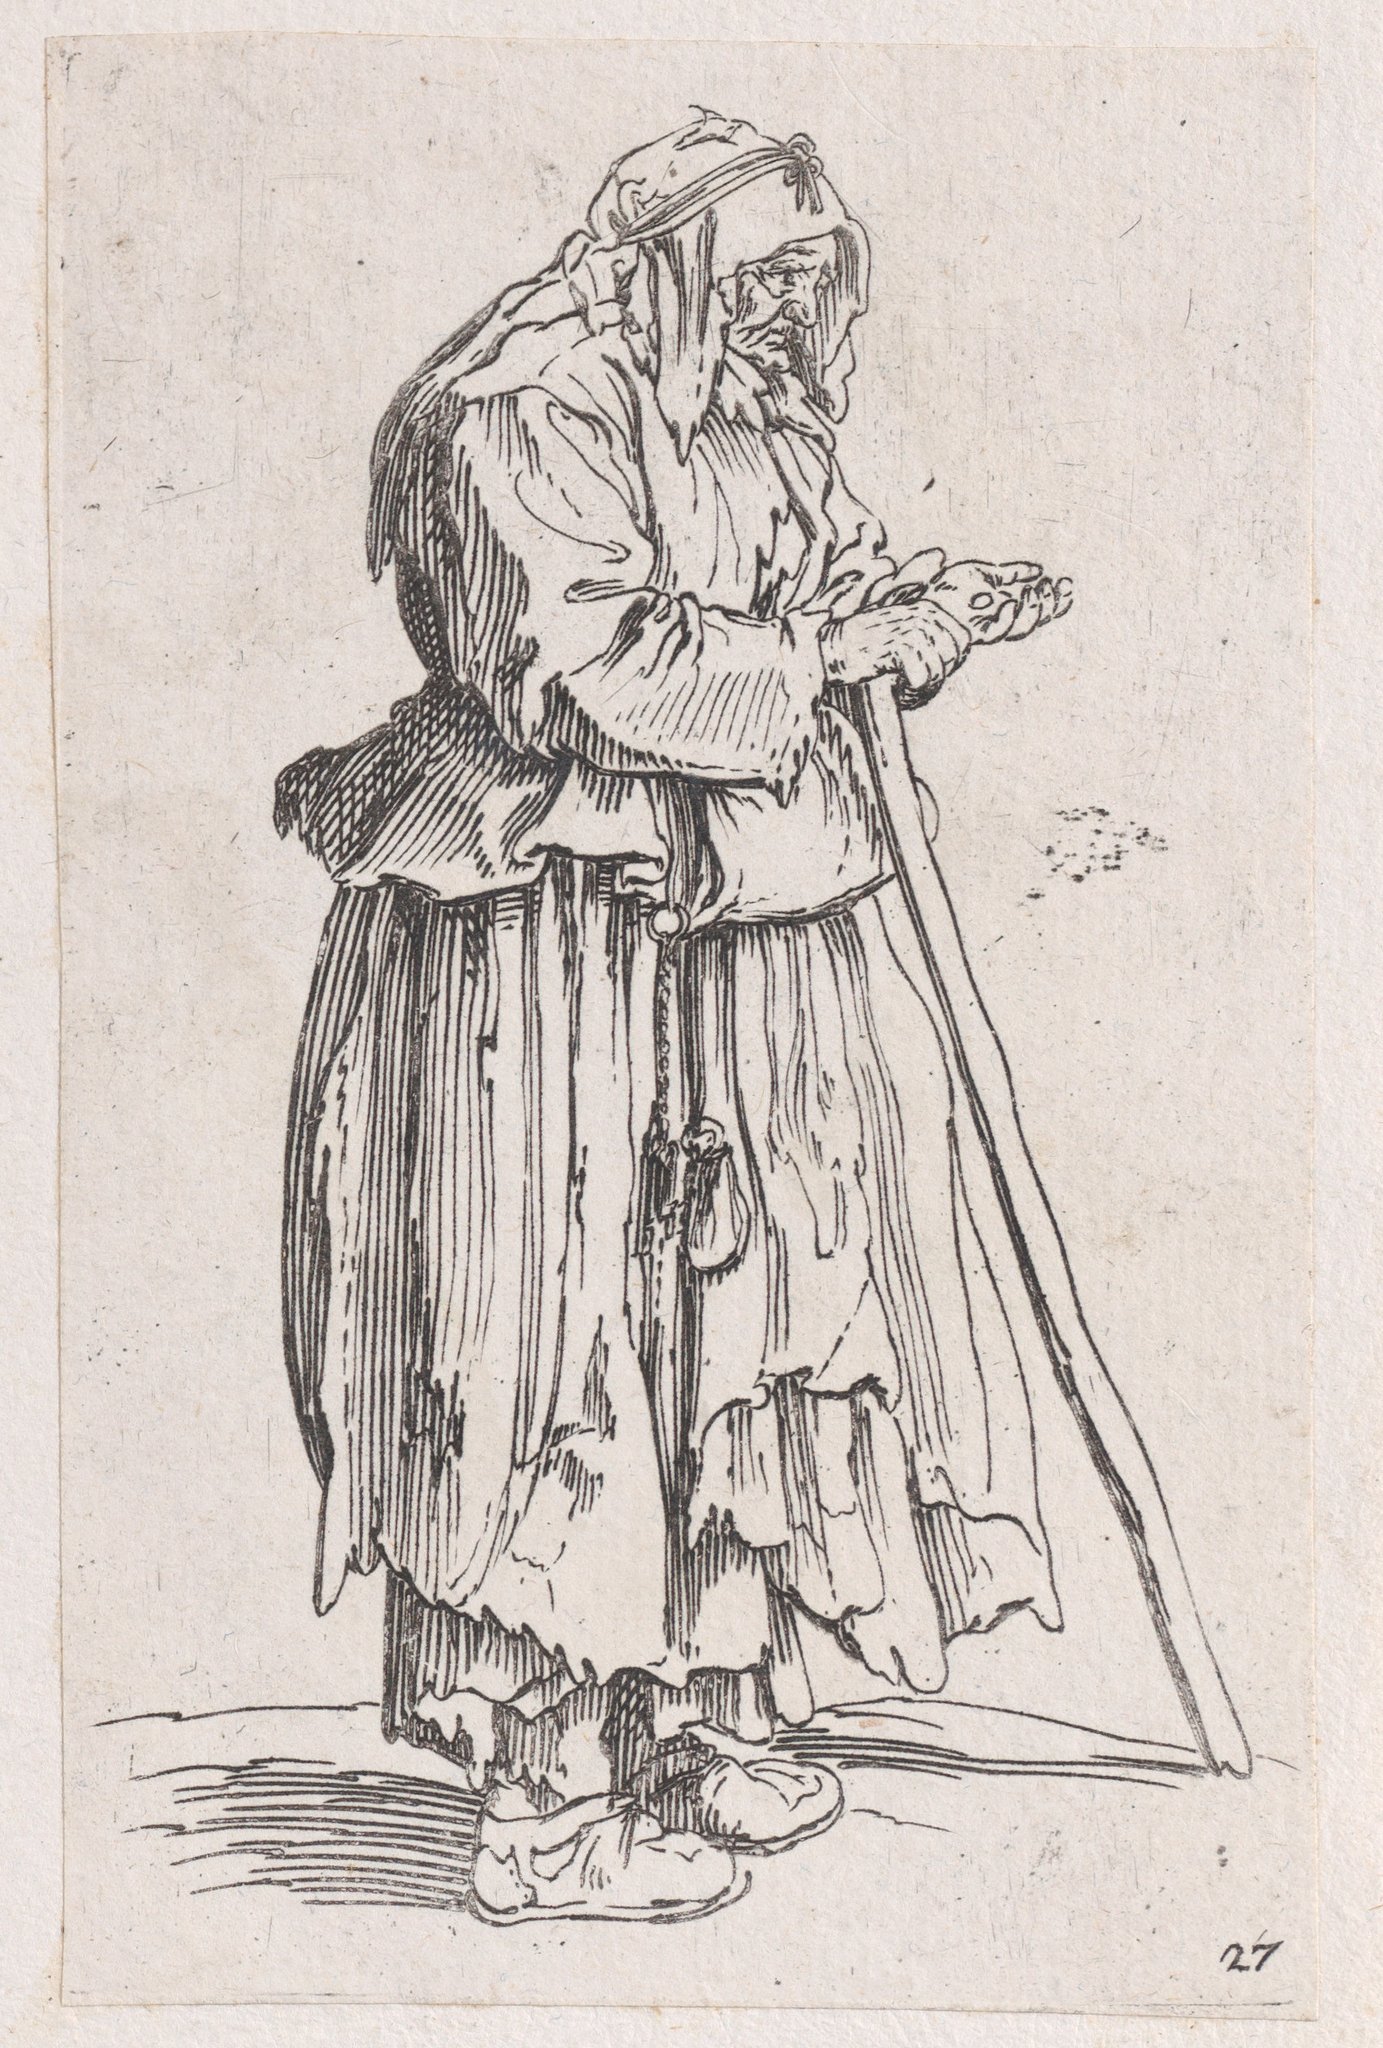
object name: print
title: Reverse Copy of Le Gentilhomme Enroulé dans son Manteau Bordé de Fourrures (The Gentleman Wrapped in his Fur Lined Mantle), from La Noblesse (The Nobility)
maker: Anonymous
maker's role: artist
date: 1601-1700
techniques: etching